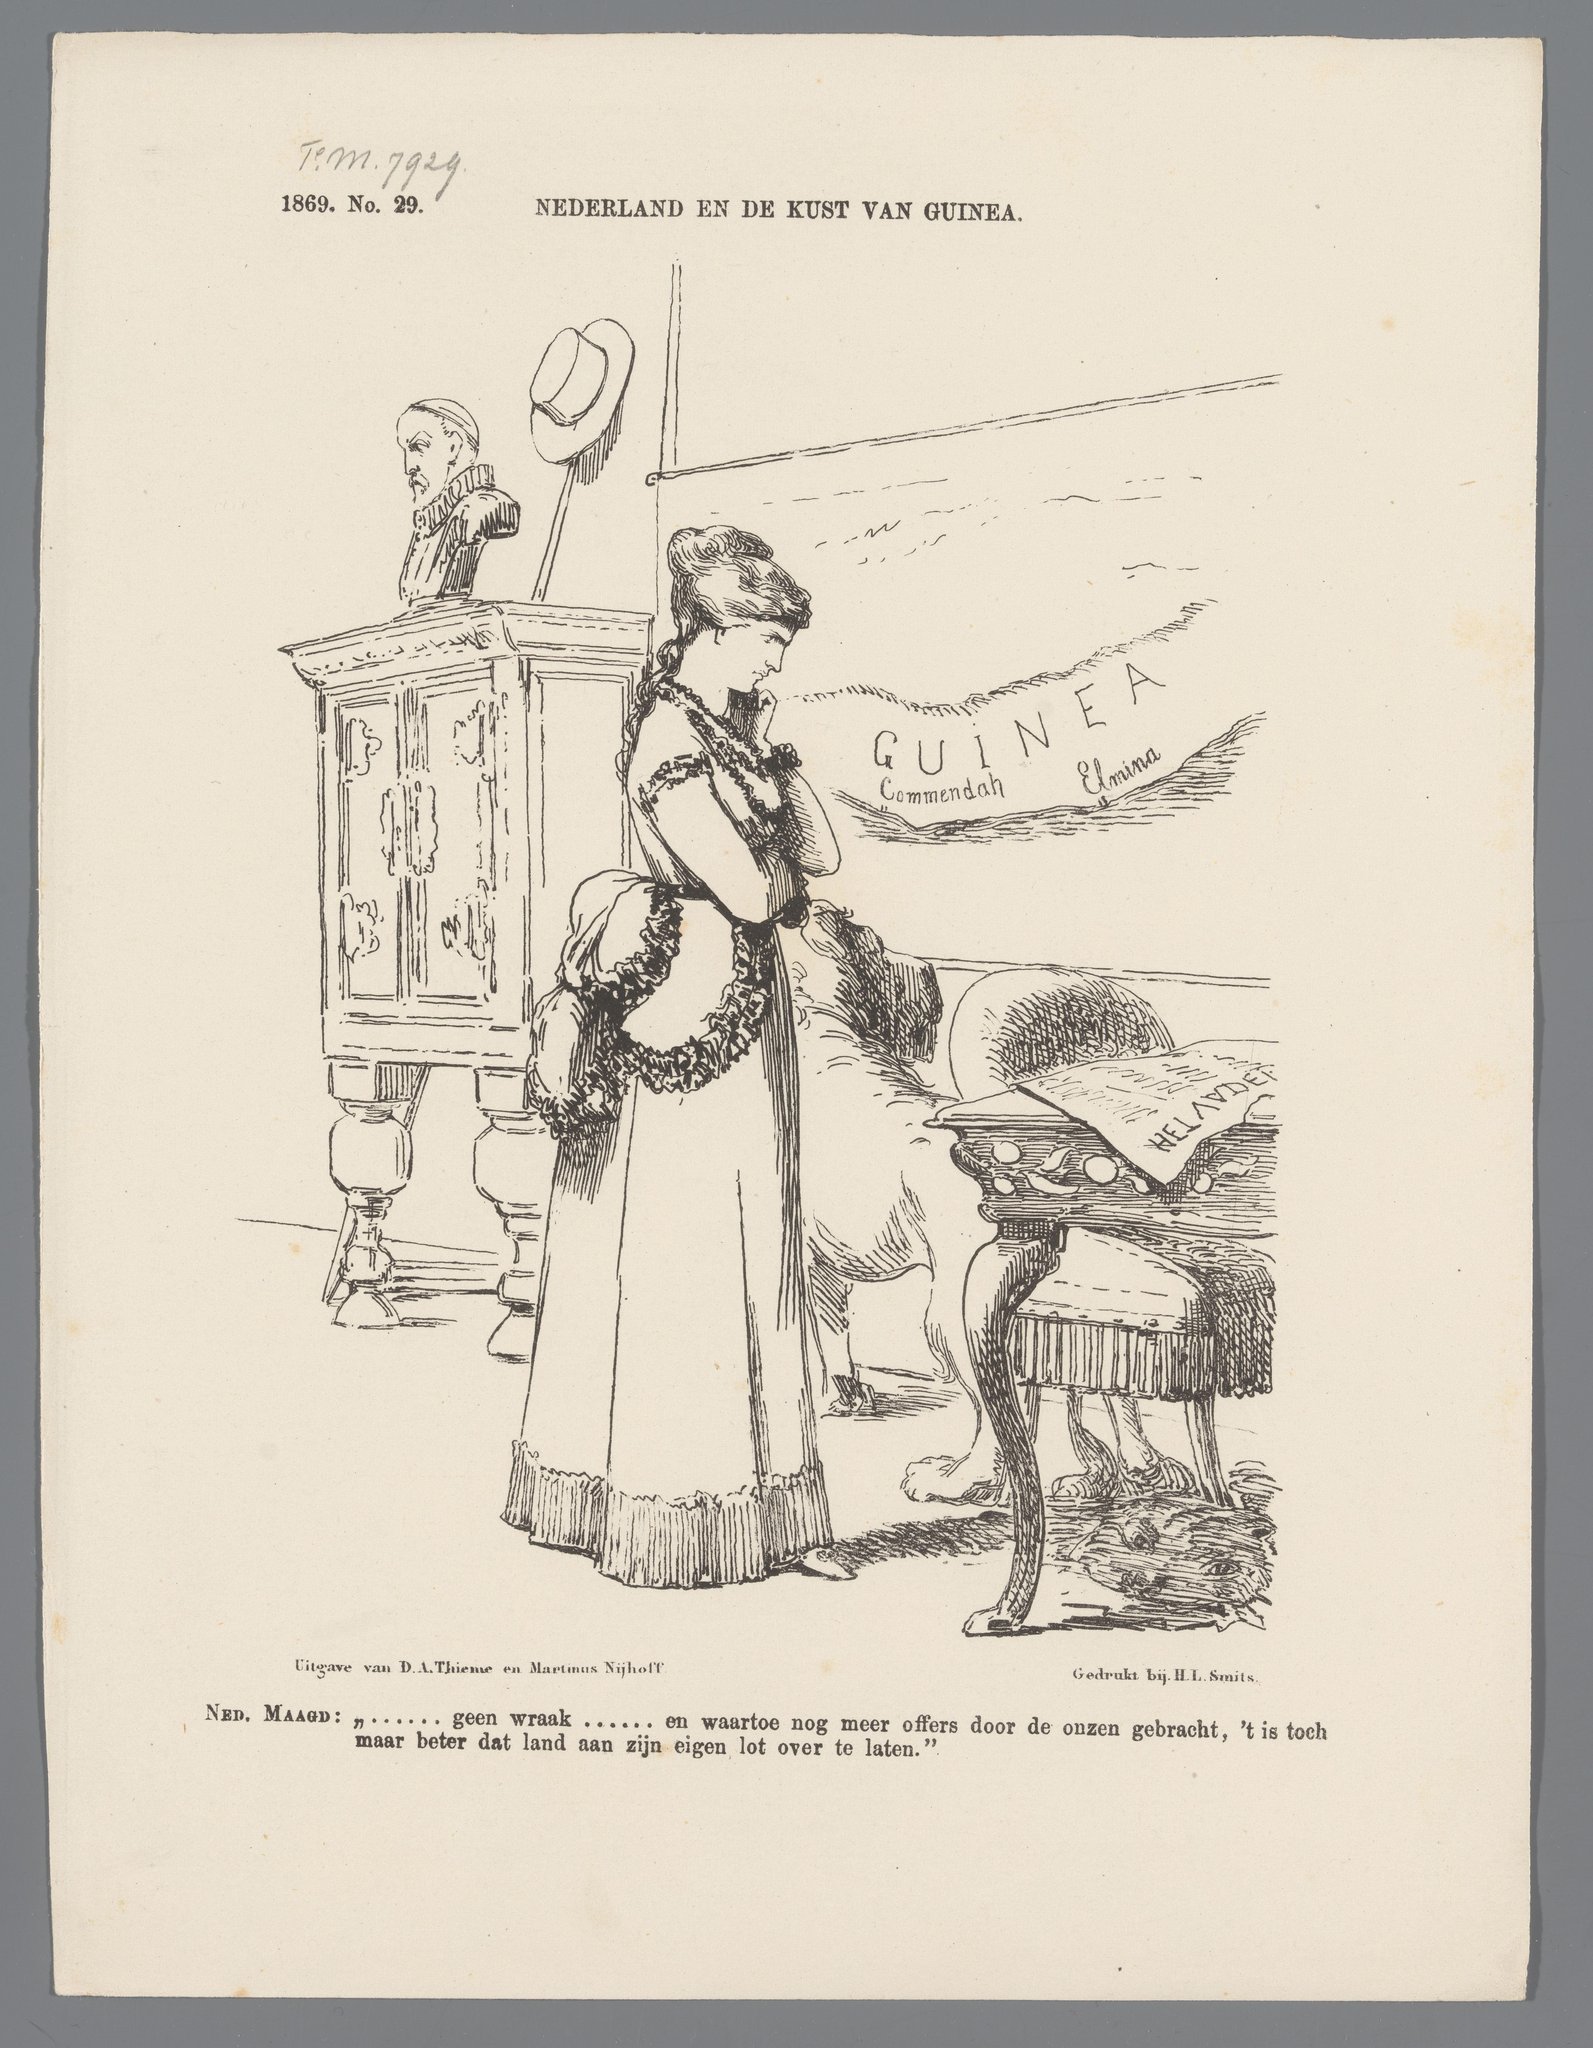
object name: cartoon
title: Spotprent over de overname van de Goudkust door de Britten, 1869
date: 1869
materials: paper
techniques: lithograph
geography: netherlands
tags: personifications of countries, nations, states, districts, etc.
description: Spotprent over de overname van de kust van Ghana door Groot-Brittannië. De Nederlandse Maagd staat peinzend bij een kaart van de kust van Guinea. Plaat verschenen bij het weekblad De Nederlandsche Spectator, nr. 29, 1869.